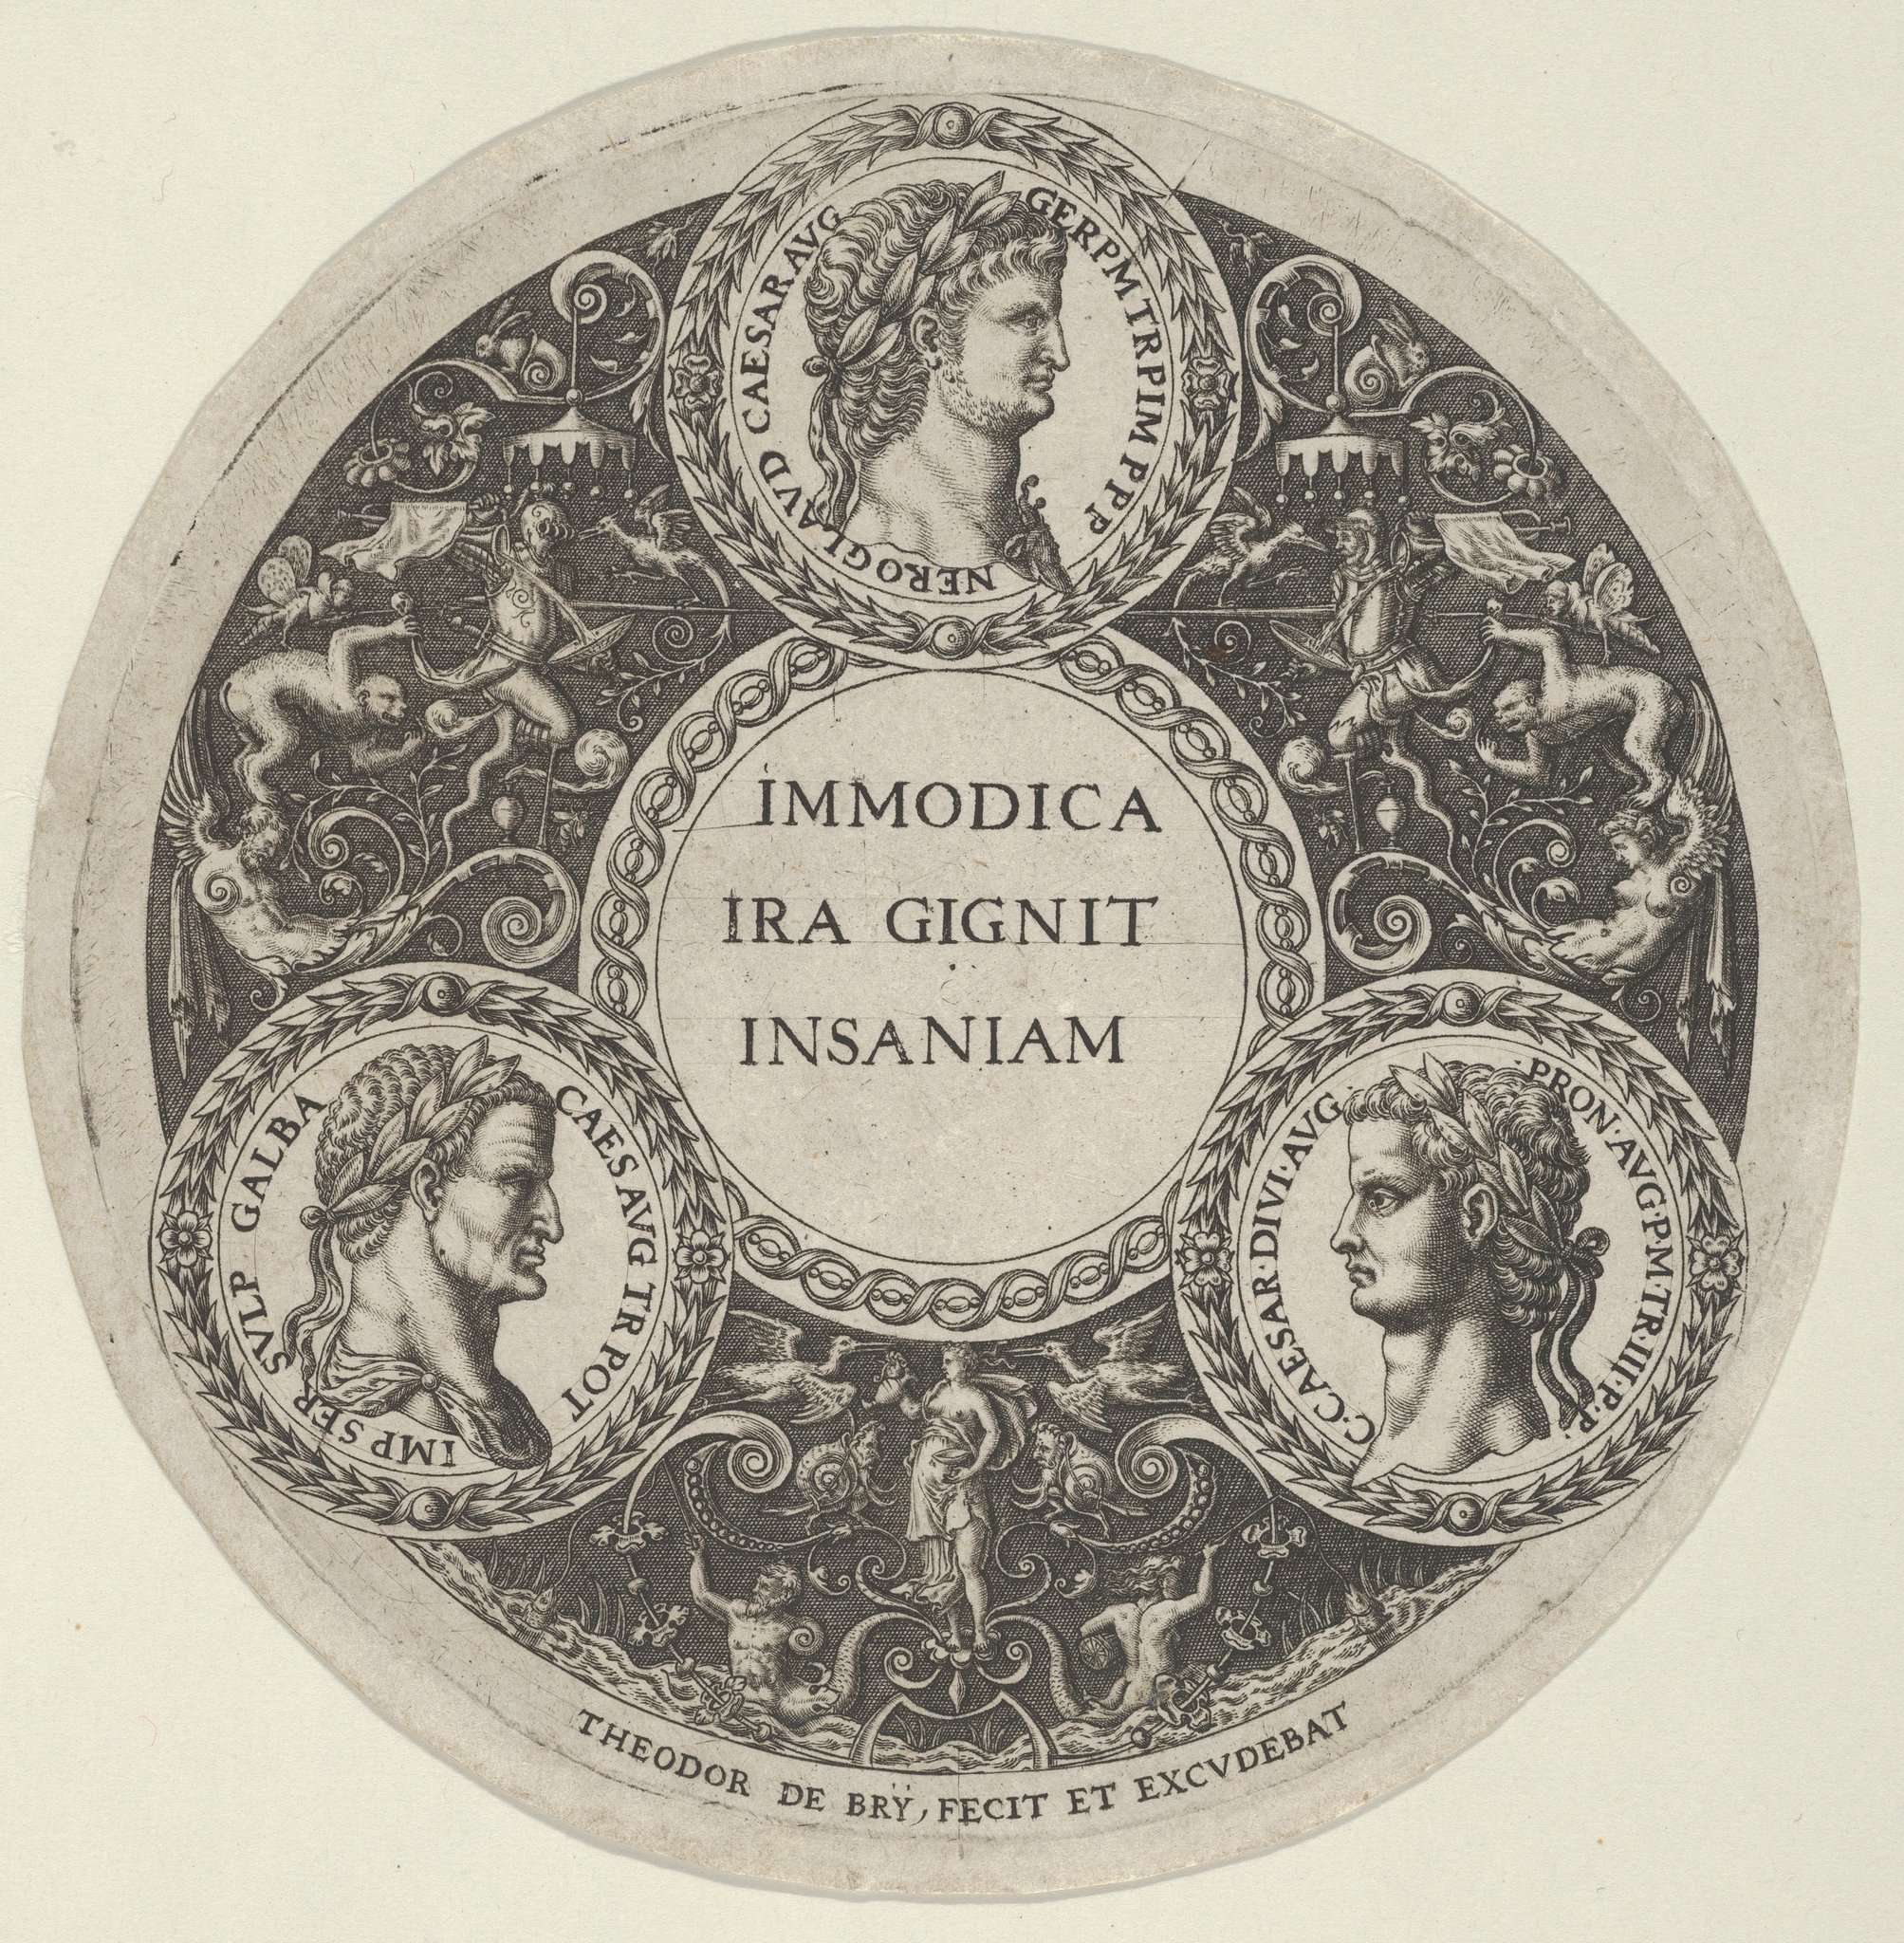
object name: print ornament architecture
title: Design for a Dish with Portraits of the Roman Emperors Nero, Galba, and Caligula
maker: theodor de bry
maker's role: artist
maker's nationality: netherlandish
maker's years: 1528-1598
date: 1588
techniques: engraving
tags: birds,nero,profiles,female nudes